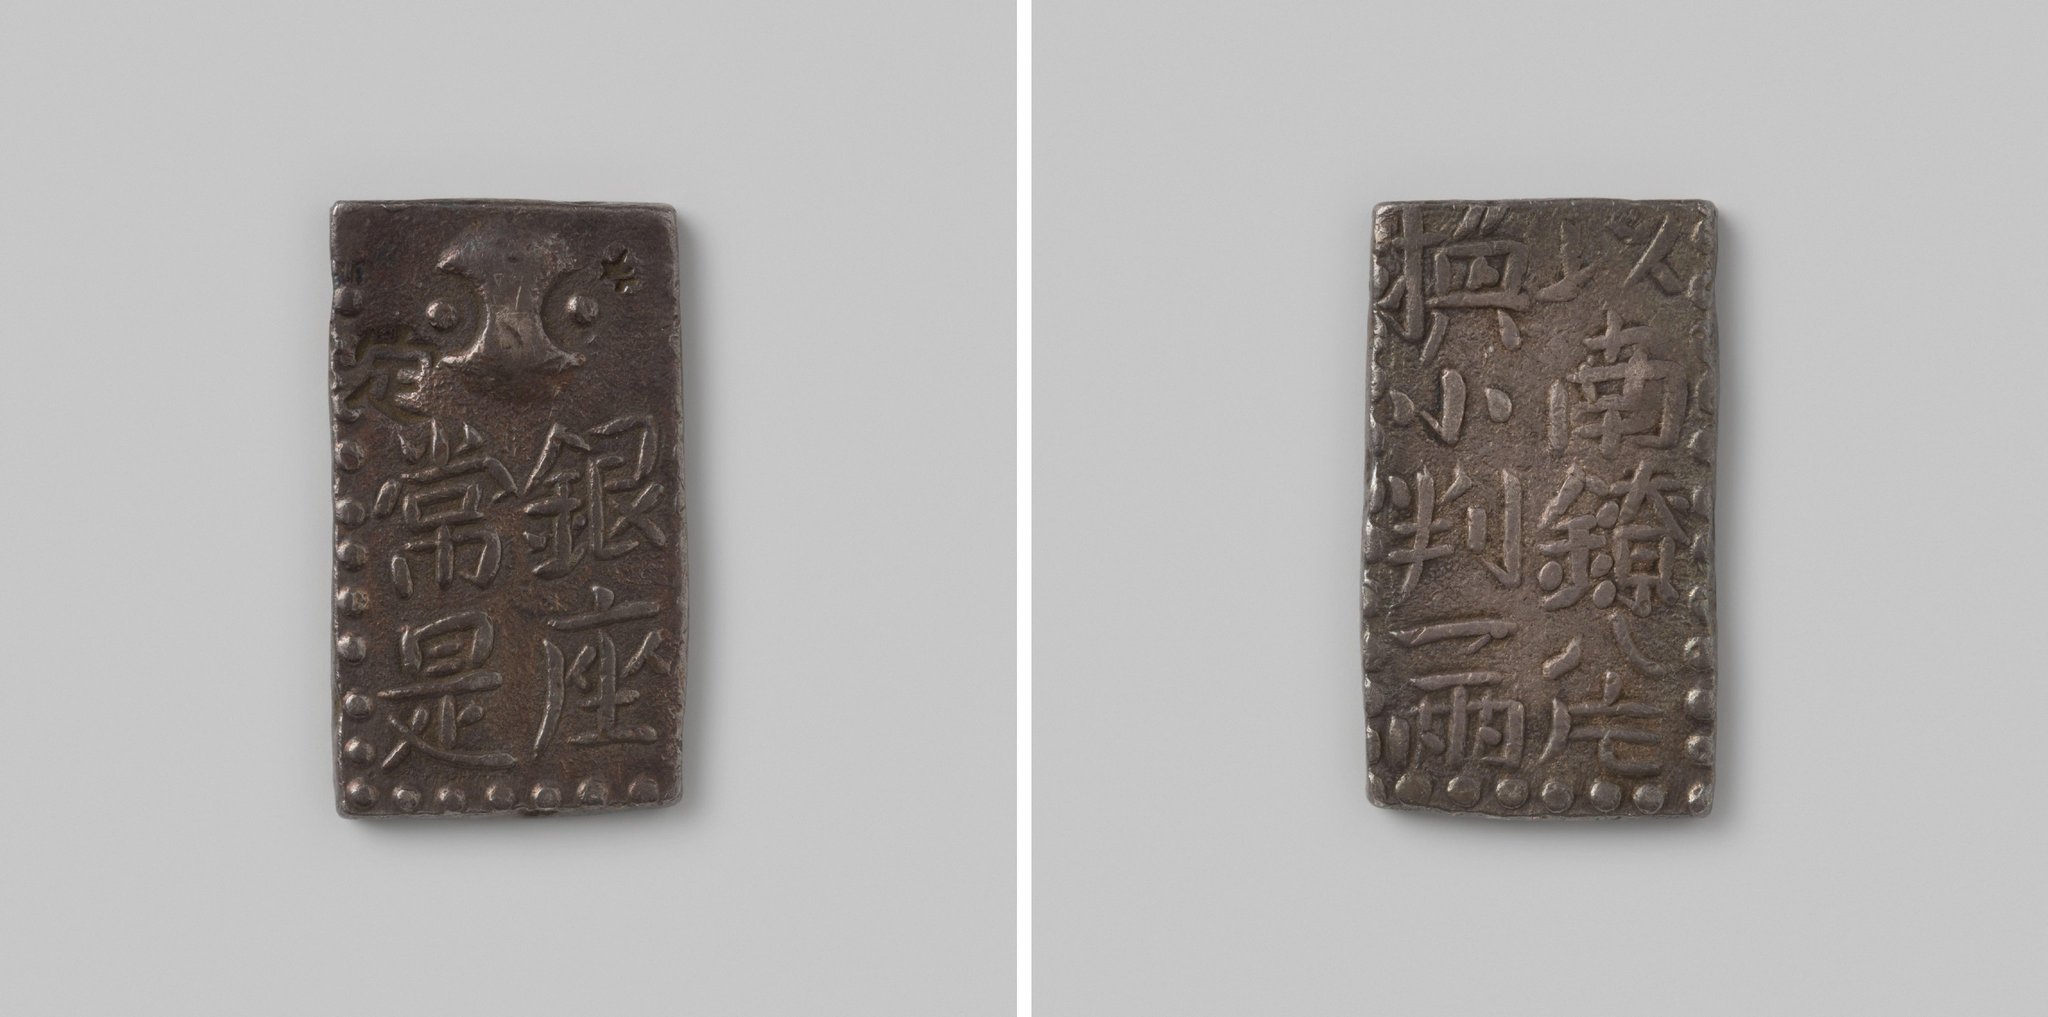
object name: coin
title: Ichi bu gin = zilveren ichi bu van het keizerrijk Japan, uit het Tenpo tijdperk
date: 1837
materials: silver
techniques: striking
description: Zilveren rechthoekige munt. Voorzijde: binnen rechthoek vier onder en naast elkaar geplaatste tekens. Daarboven versiering. Keerzijde: binnen rechthoek acht onder en naast elkaar geplaatste tekens, waaronder waarde-aanduiding., waartussen waarde-aanduiding: ichi = een, aangegeven door een liggende streep rechts en links het letterteken voor bu met het teken voor het tenpo tijdperk.